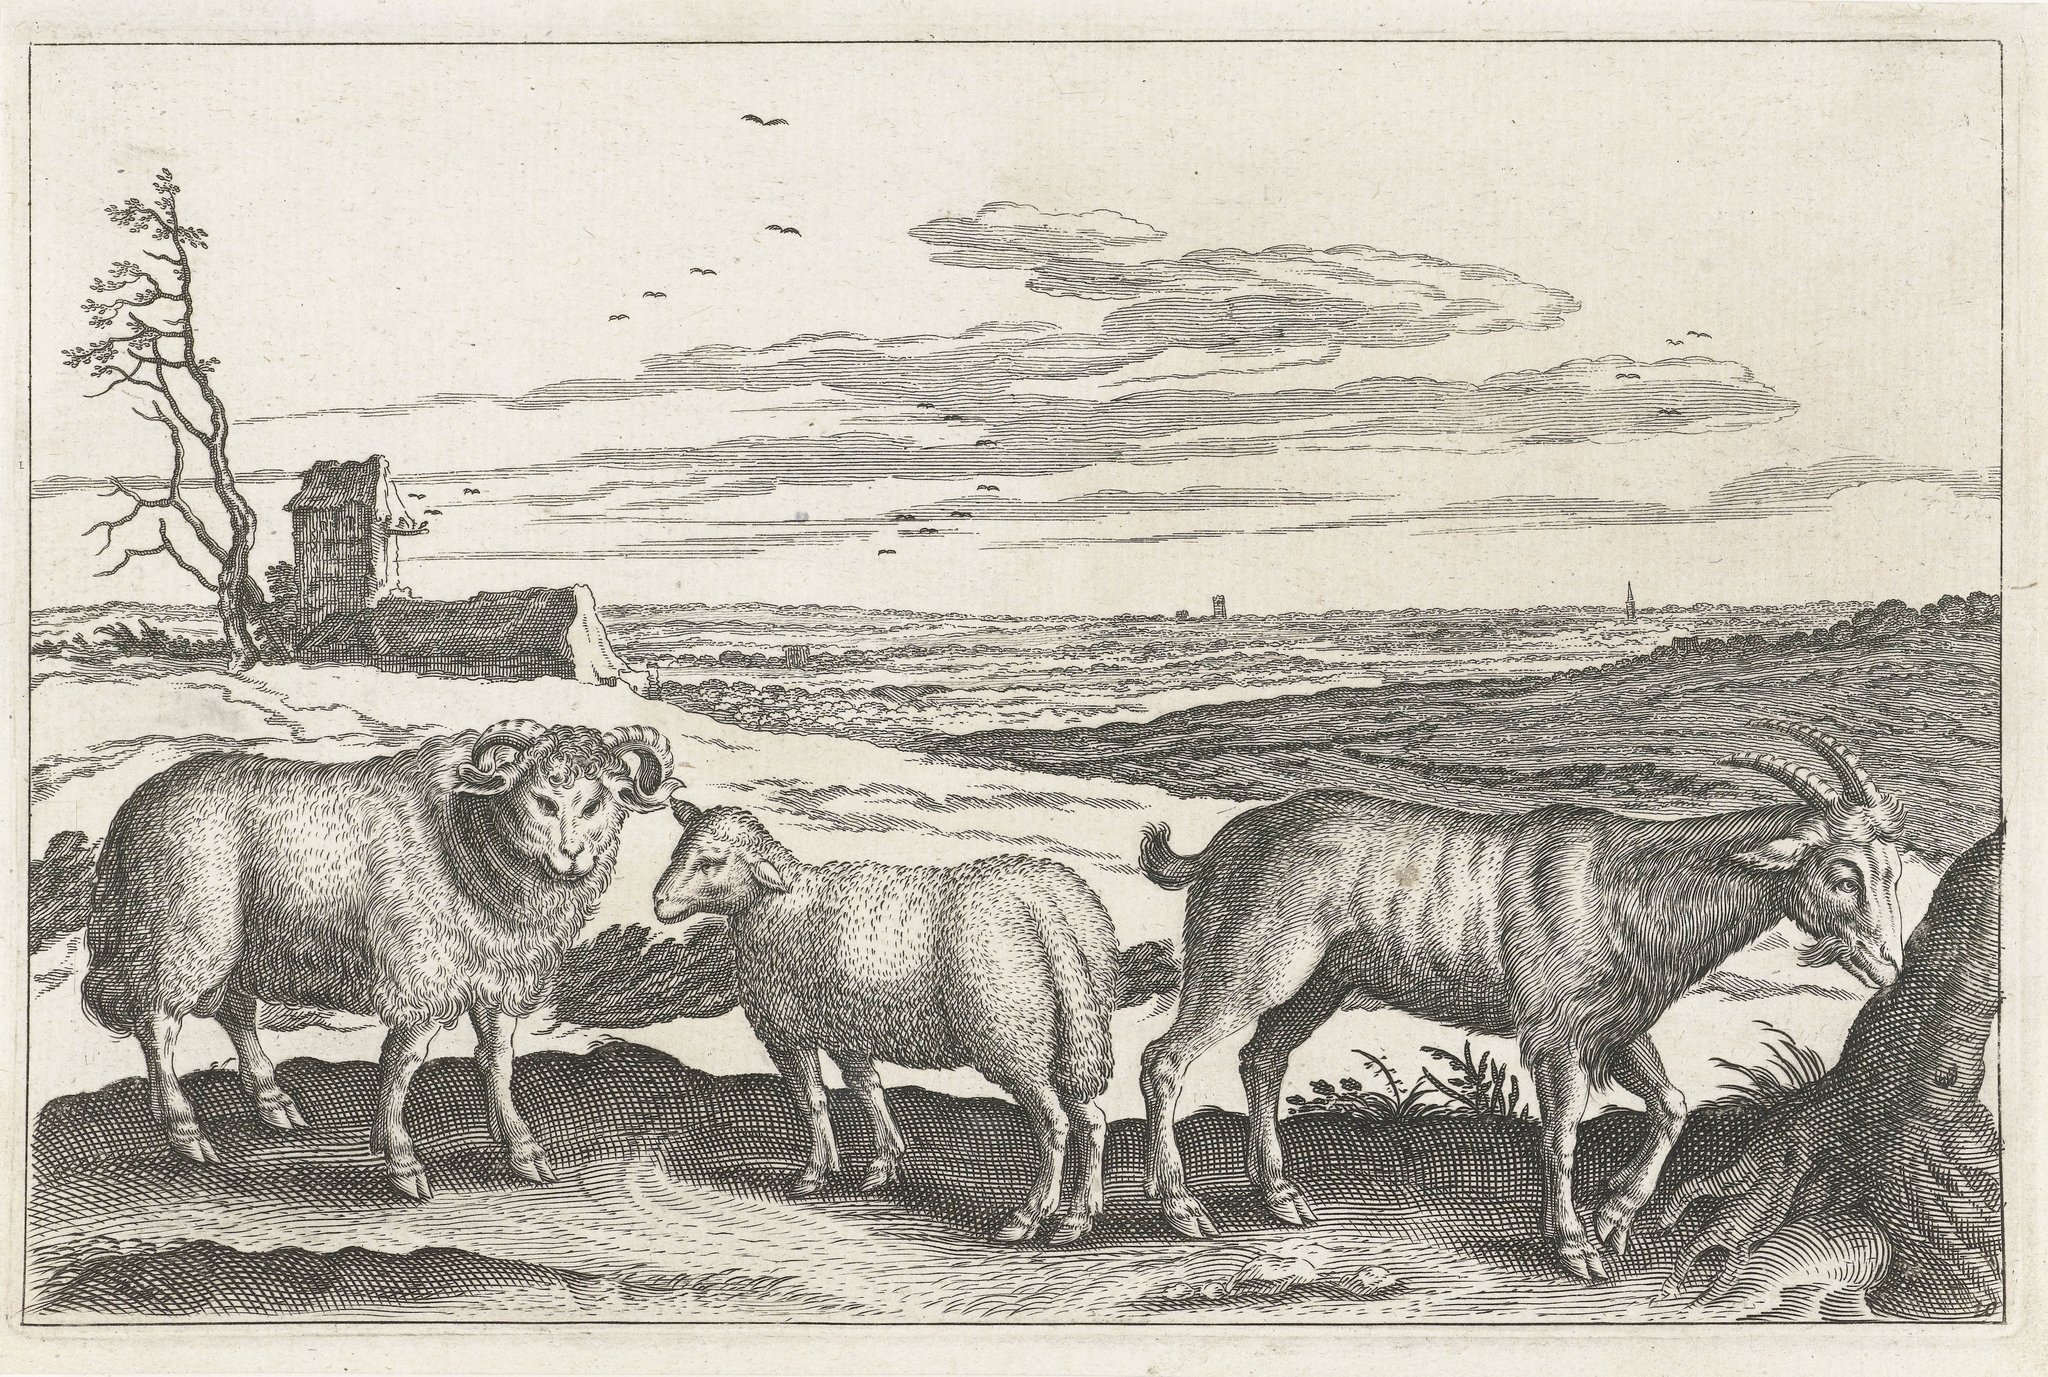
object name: print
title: Animalivm Qvaddrvpedvm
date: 1628-1679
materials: paper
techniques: engraving, etching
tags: landscapes, ram, ewe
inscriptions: collector's mark: Lugt 2228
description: Een bok, een ooi en een ram op de voorgrond. Op de achtergrond een landschap. De prent maakt deel uit van een serie met als onderwerp dieren.